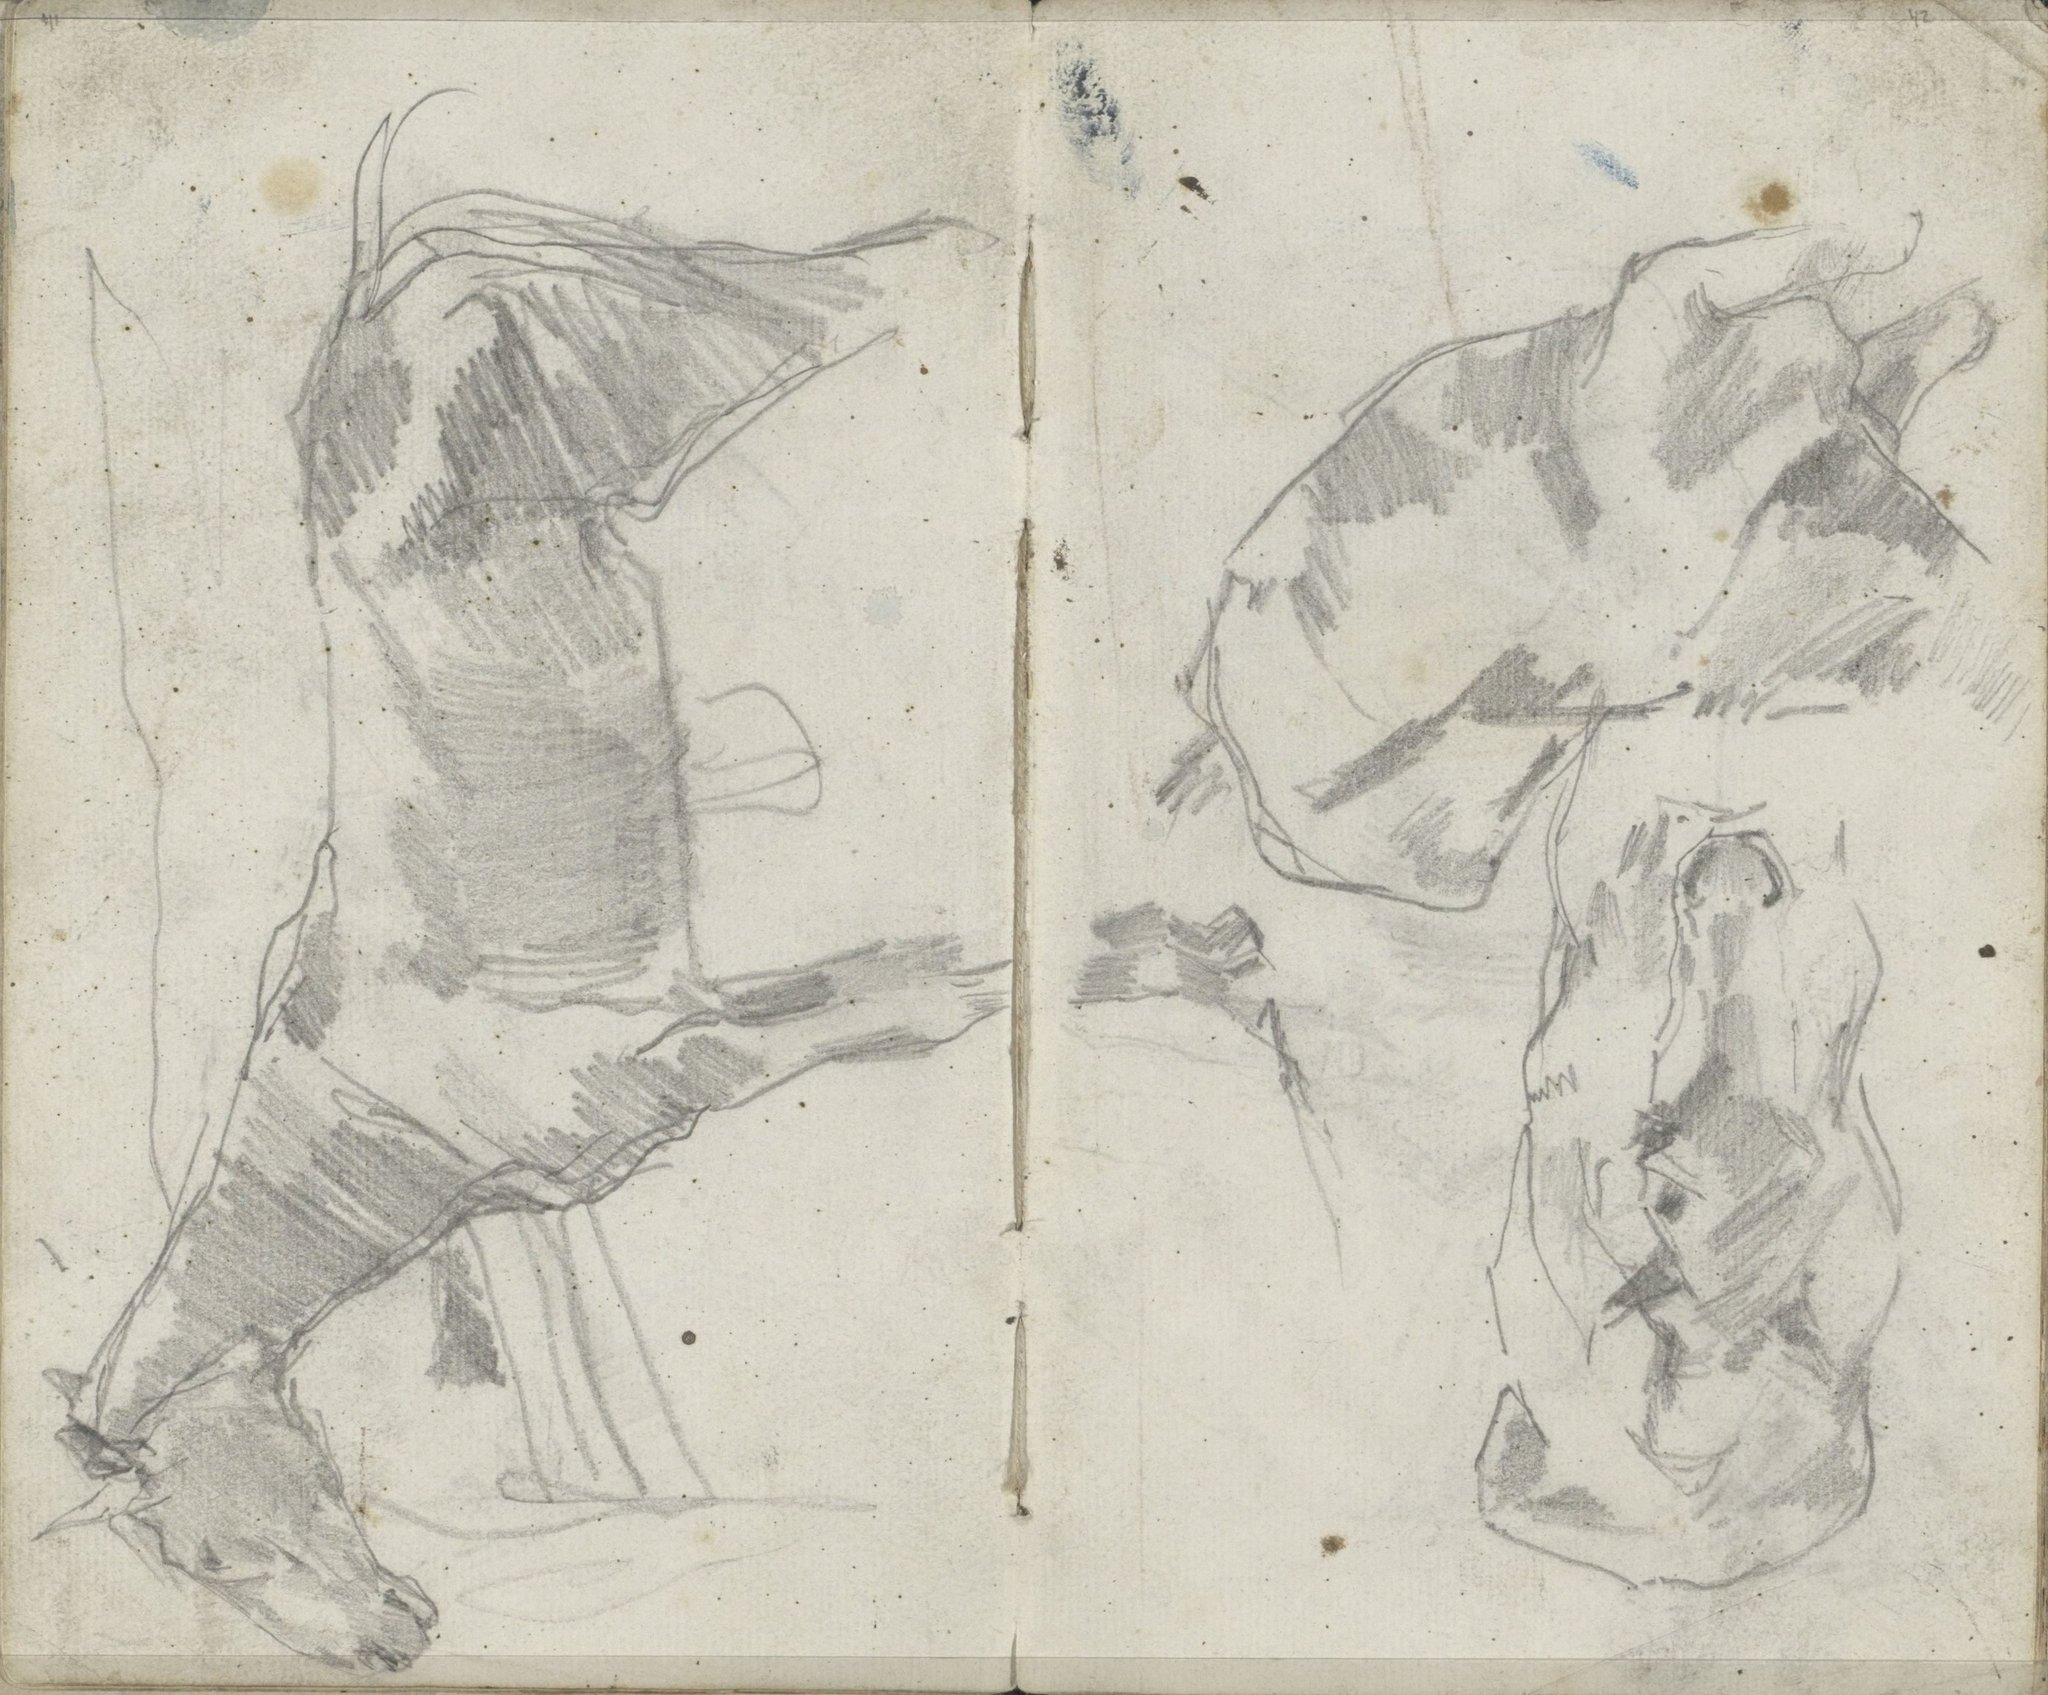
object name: sketchbook leaf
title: Studieblad met paarden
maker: george hendrik breitner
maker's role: draughtsman, painter, print maker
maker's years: 1857-1923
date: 1881-1883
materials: paper, pencil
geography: the hague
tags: horse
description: Pagina 41 en pagina 42 uit een schetsboek met 27 bladen